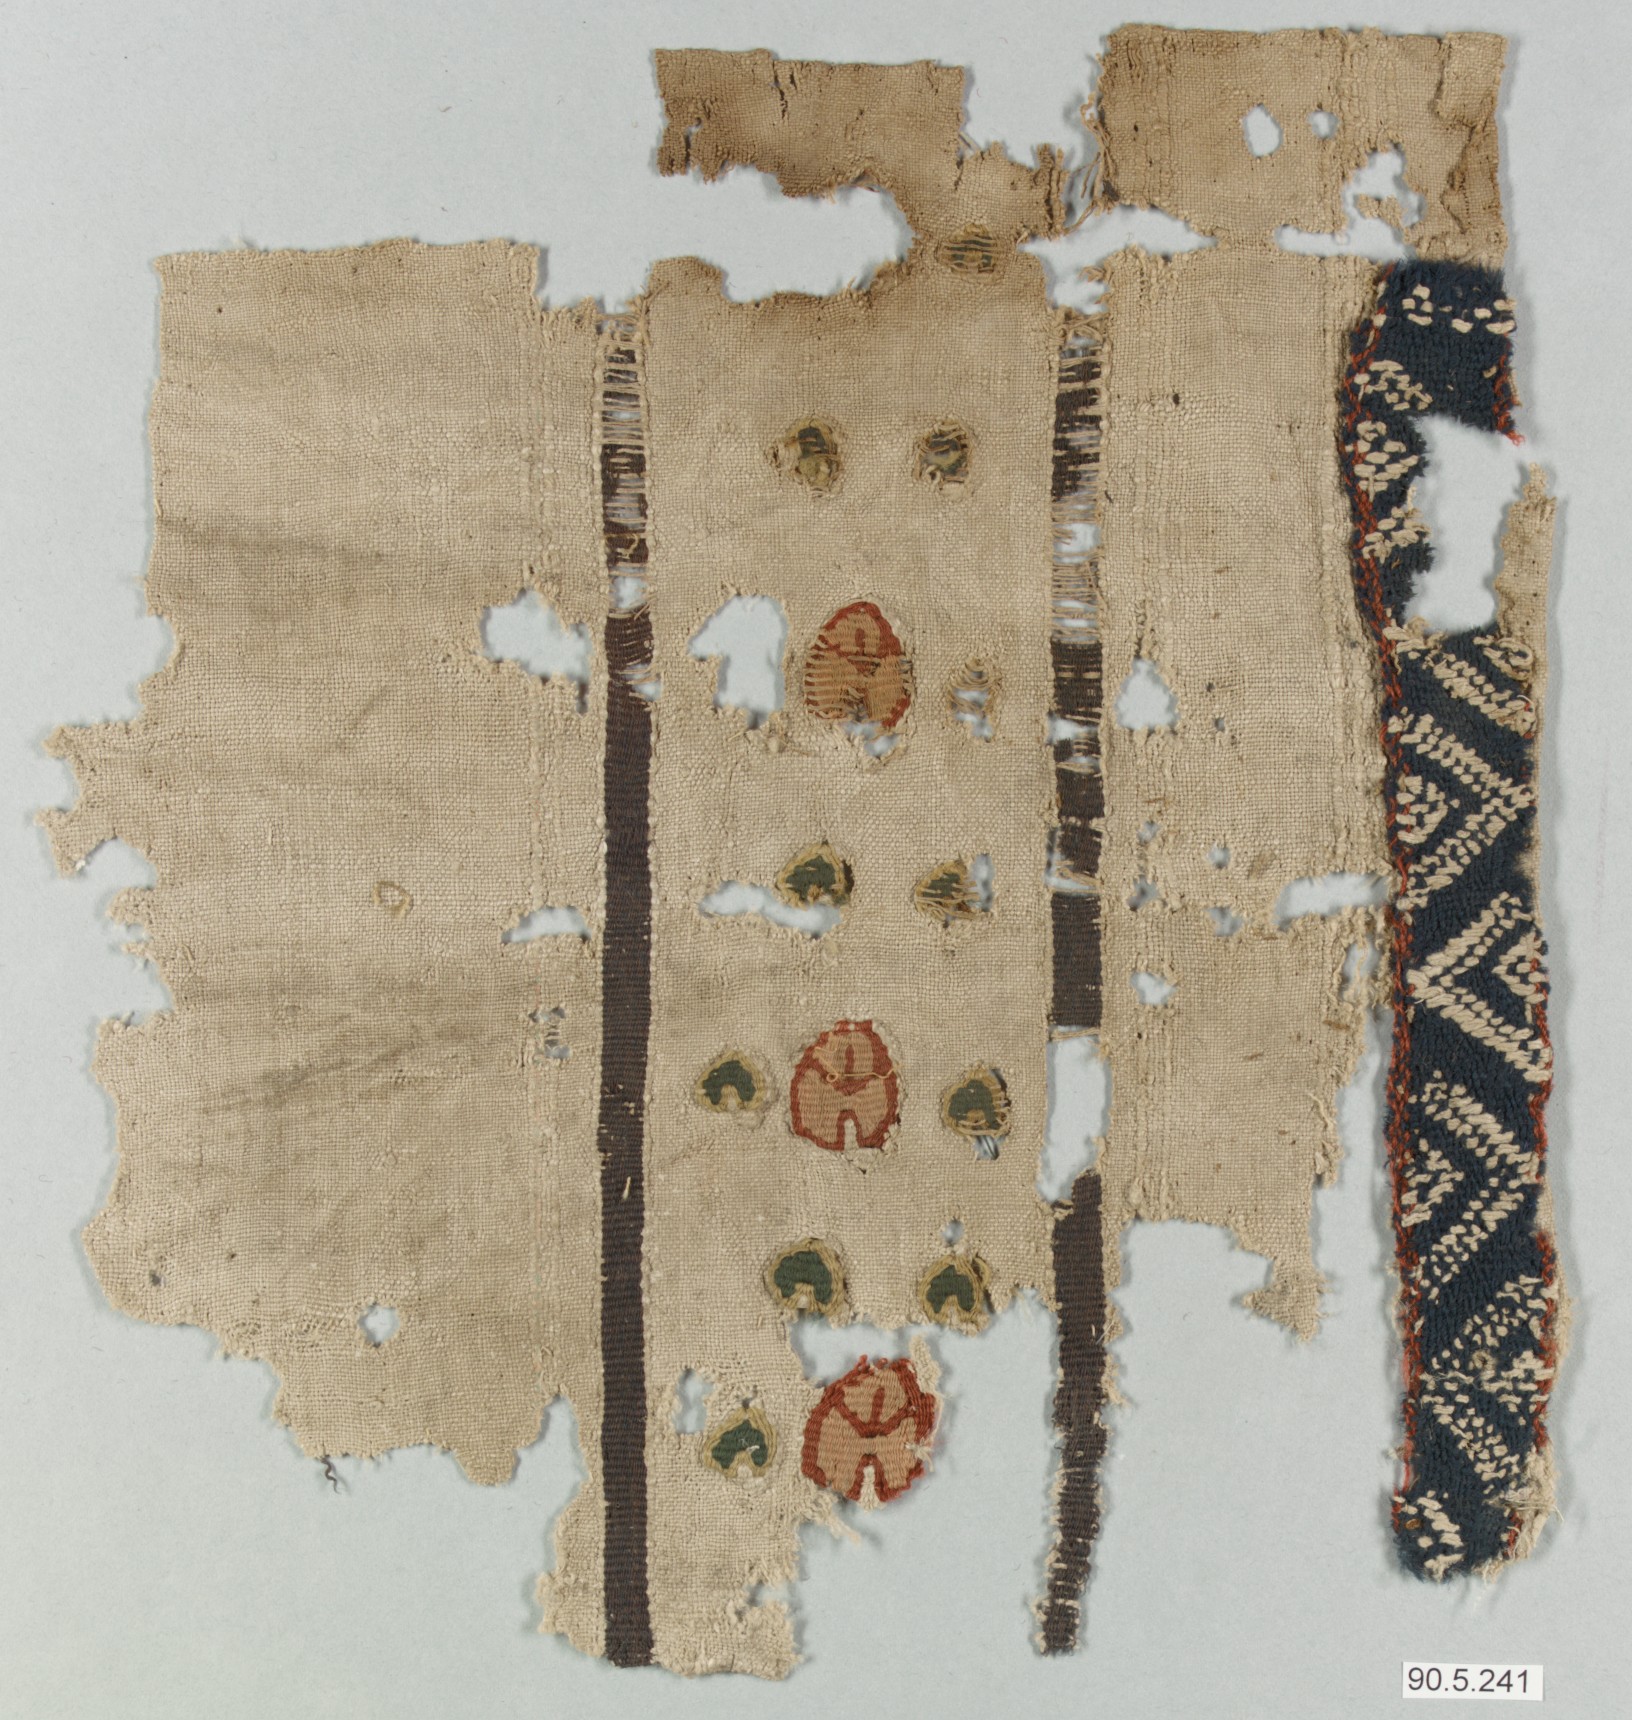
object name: textile fragment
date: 401-600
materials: linen, wool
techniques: weave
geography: egypt